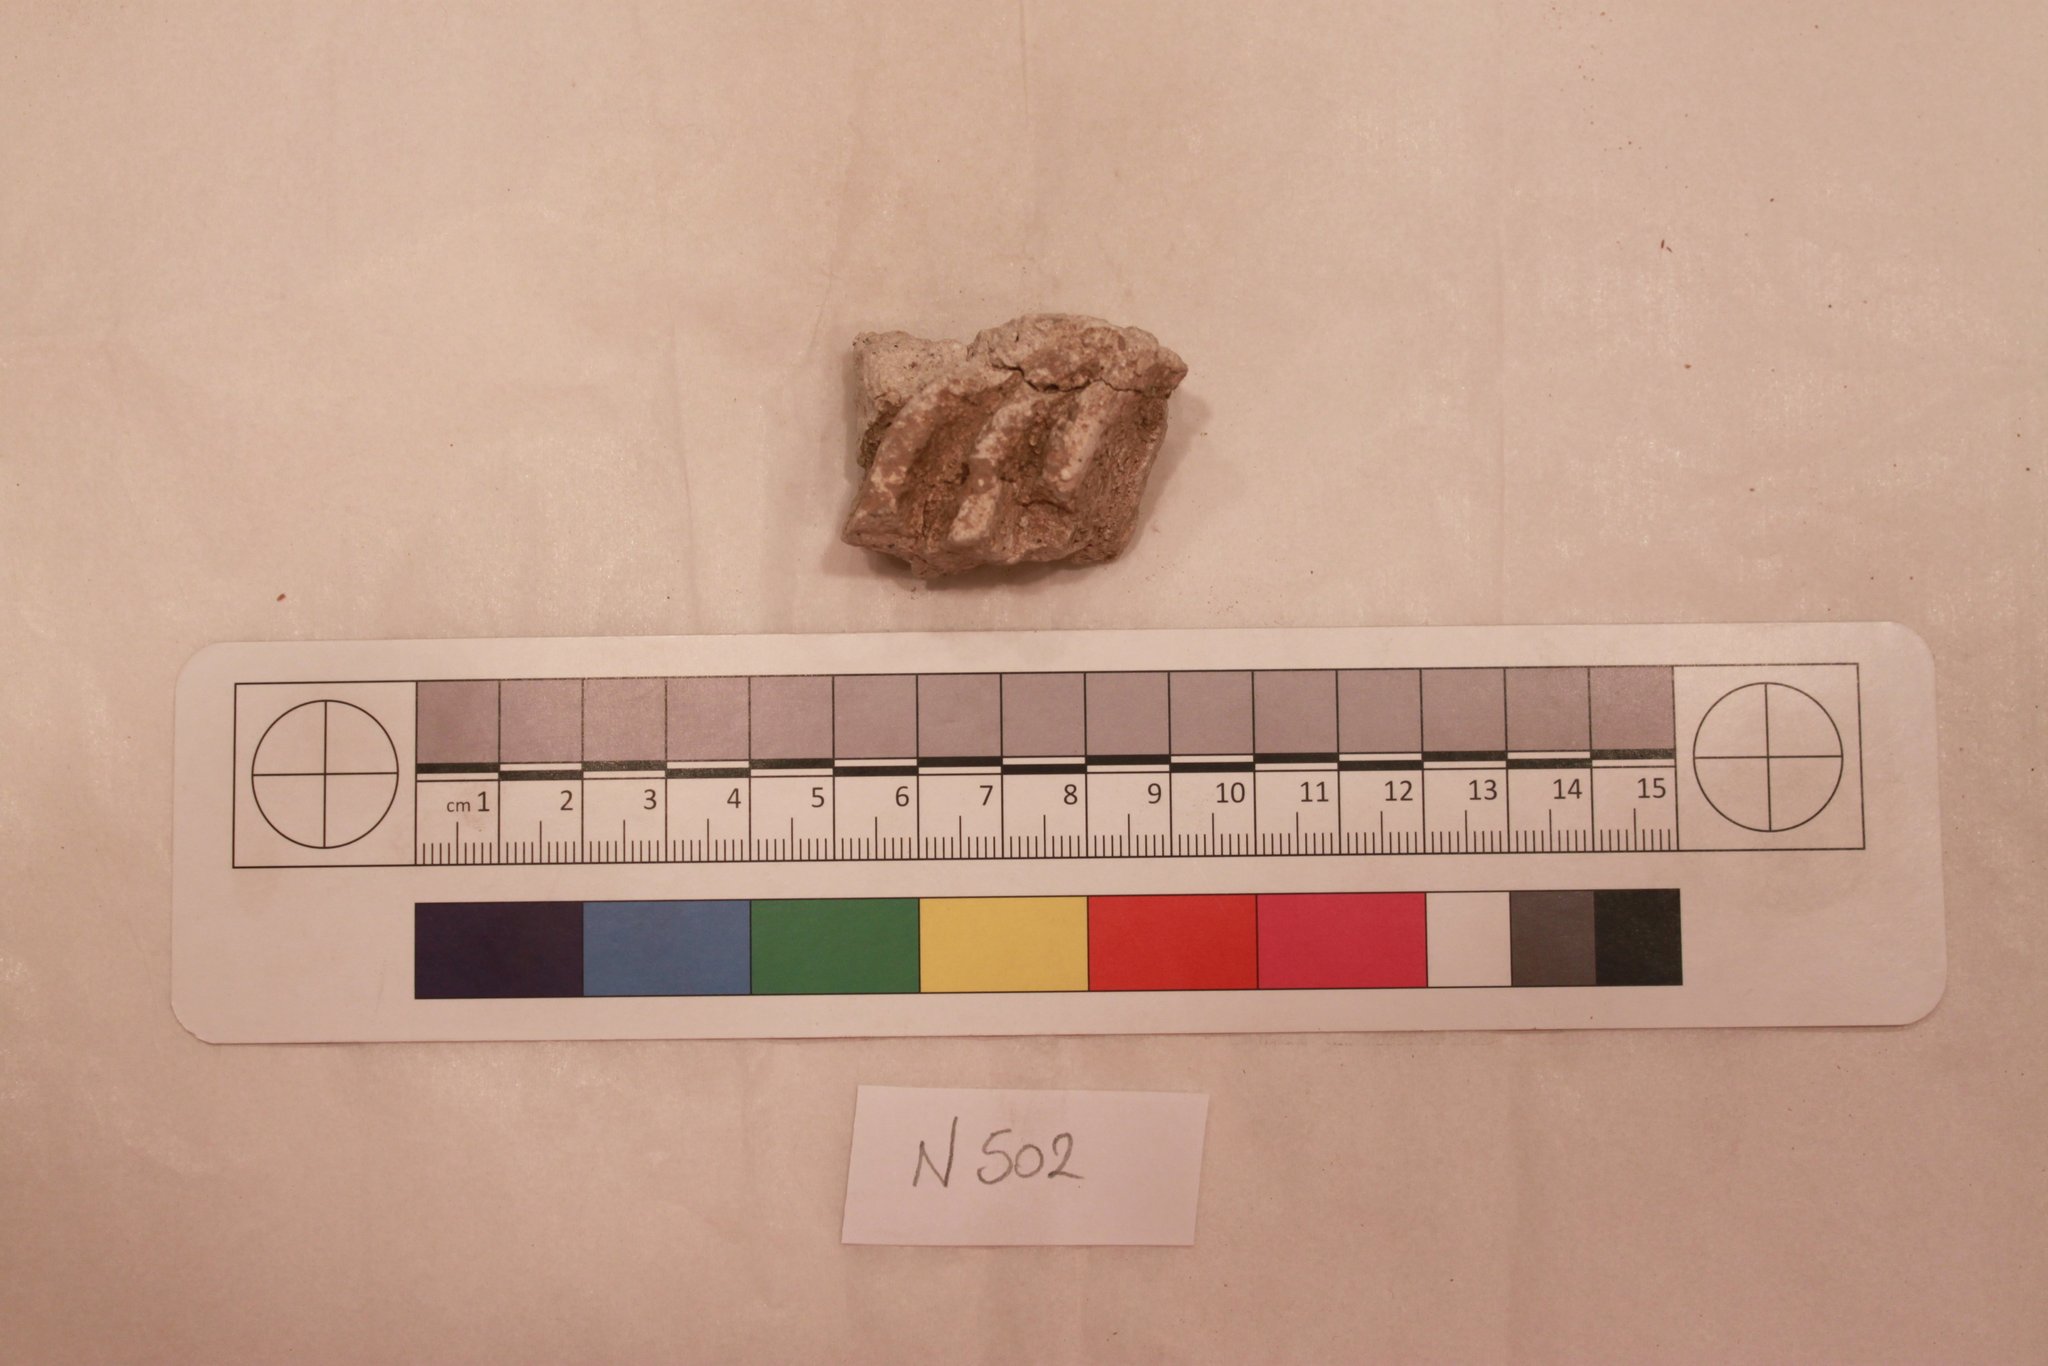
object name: fragment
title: Stucco Fragment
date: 701-1200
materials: plaster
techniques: carving, painting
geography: iran